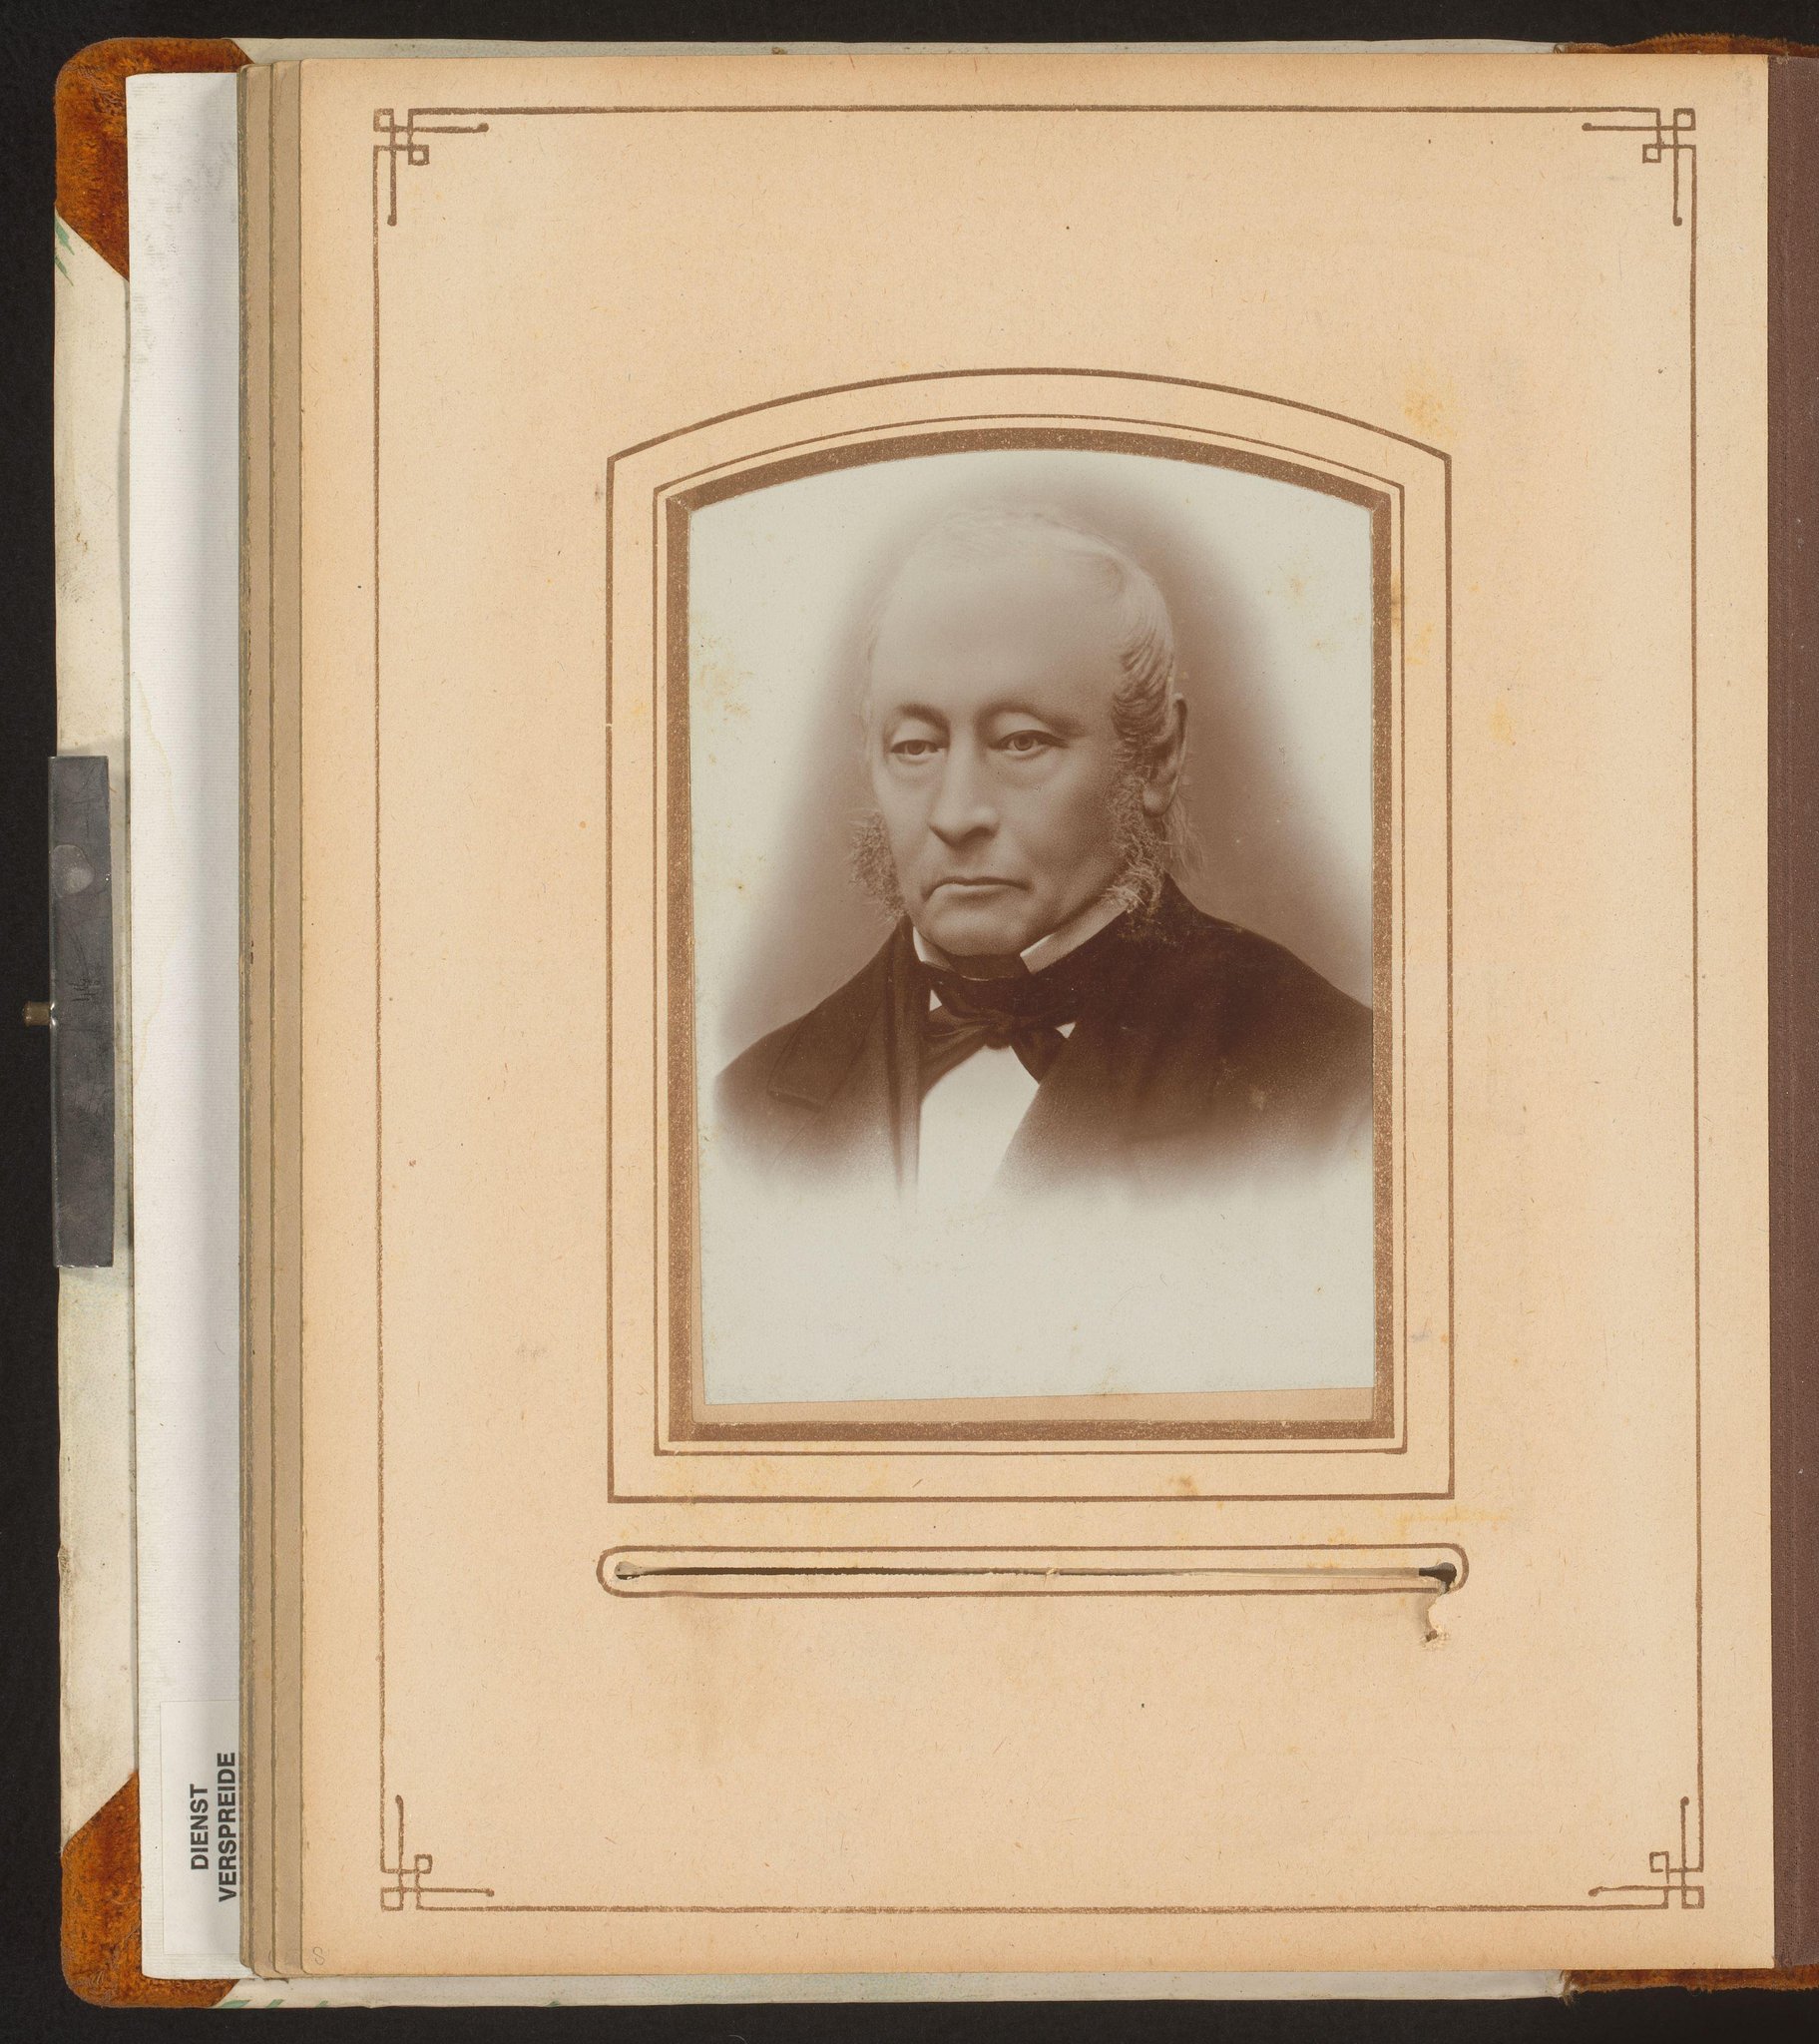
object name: album leaf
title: Portret van een man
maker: Anonymous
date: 1870-1910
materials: cardboard, photographic support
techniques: collodion silver print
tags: adult man, historical persons